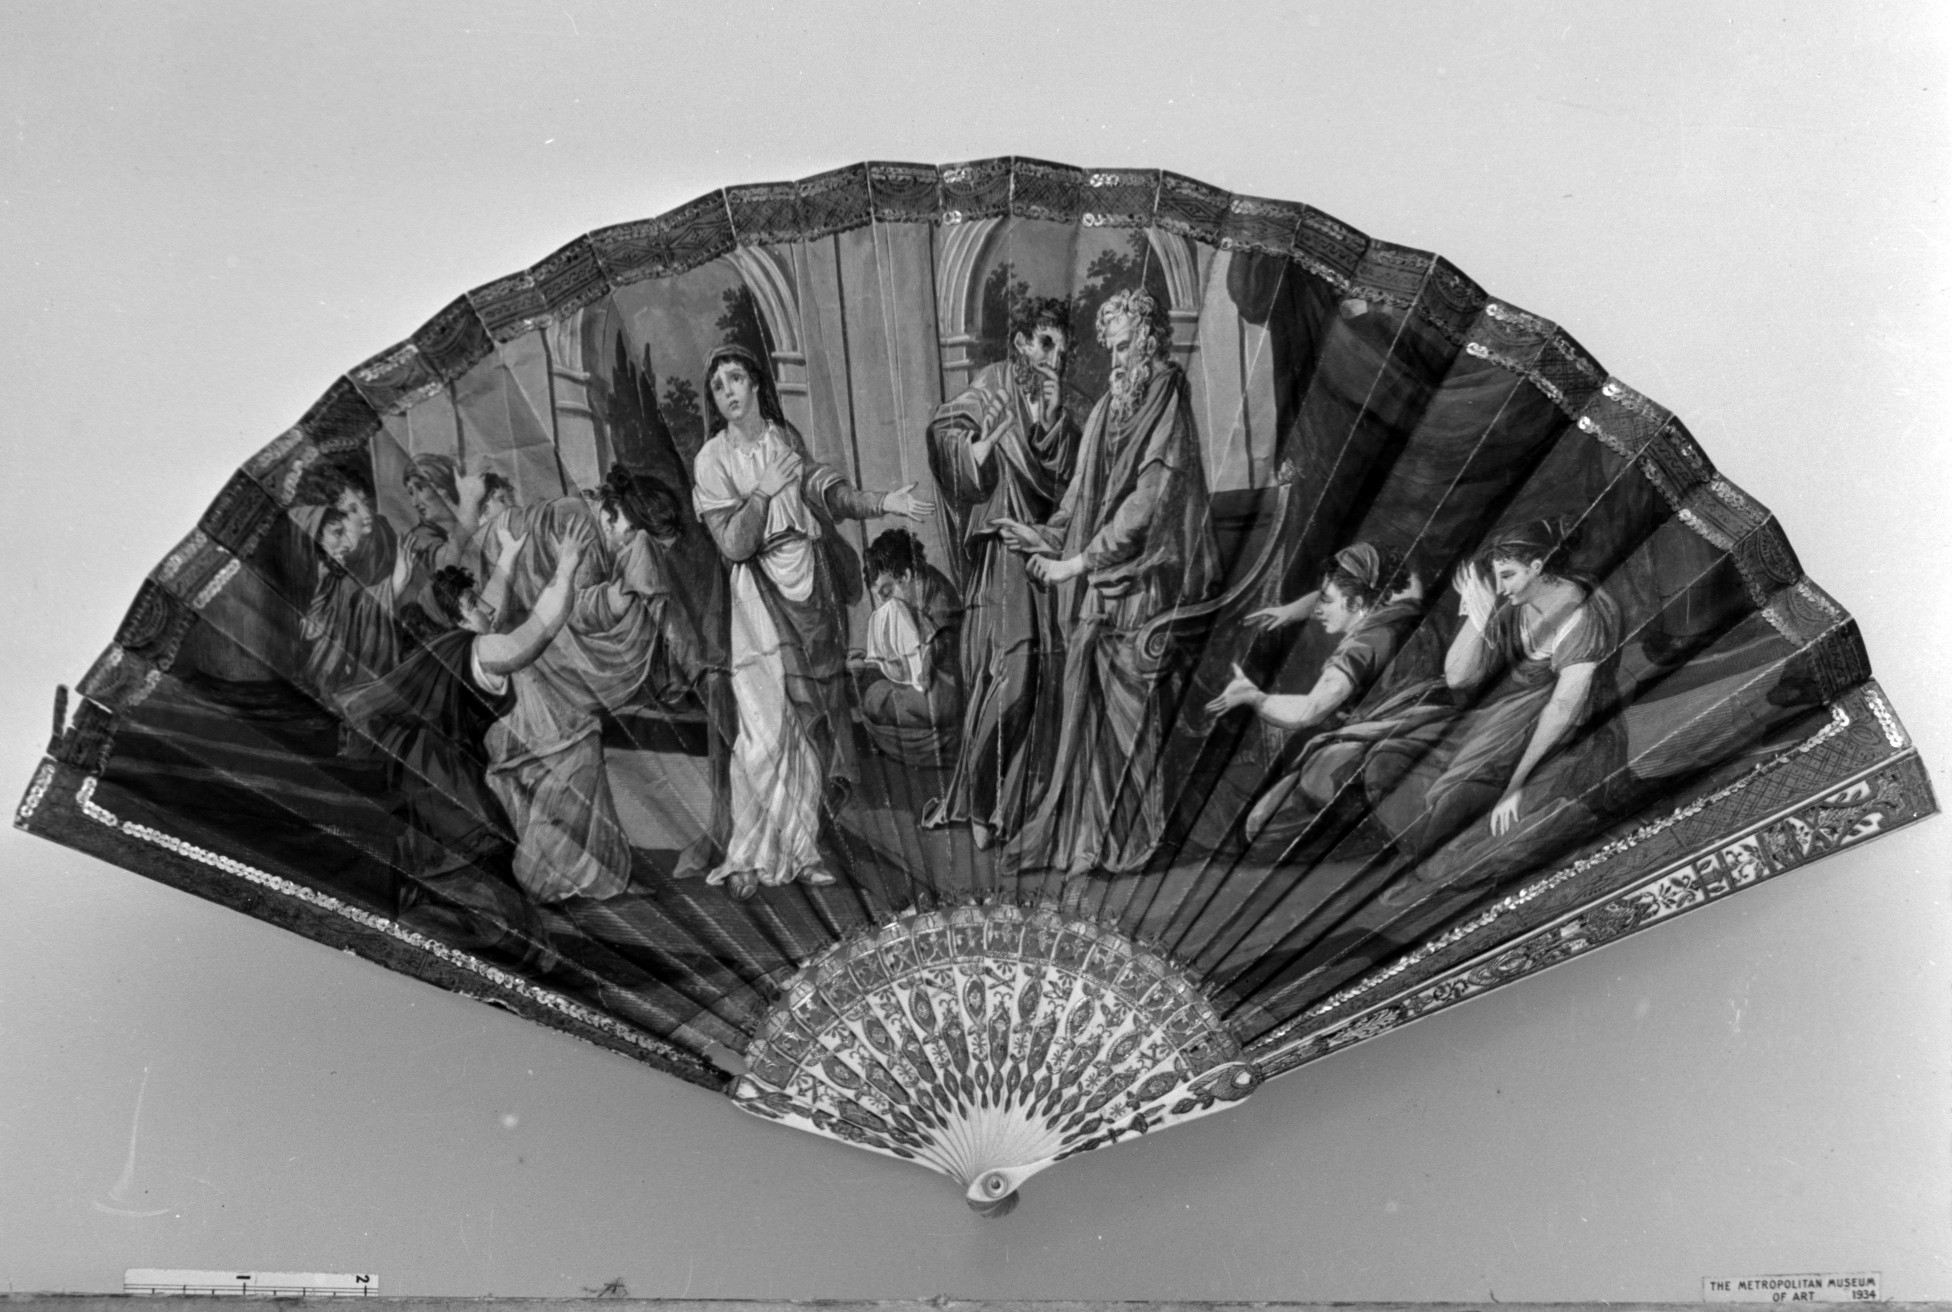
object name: fan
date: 1815-1830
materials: ivory, mother of pearl, paper, skin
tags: sadness,men,women